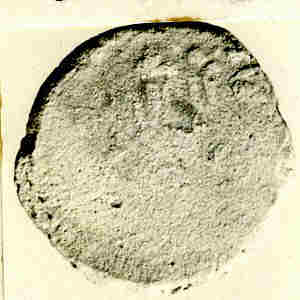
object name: coin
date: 819-1005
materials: silver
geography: iran